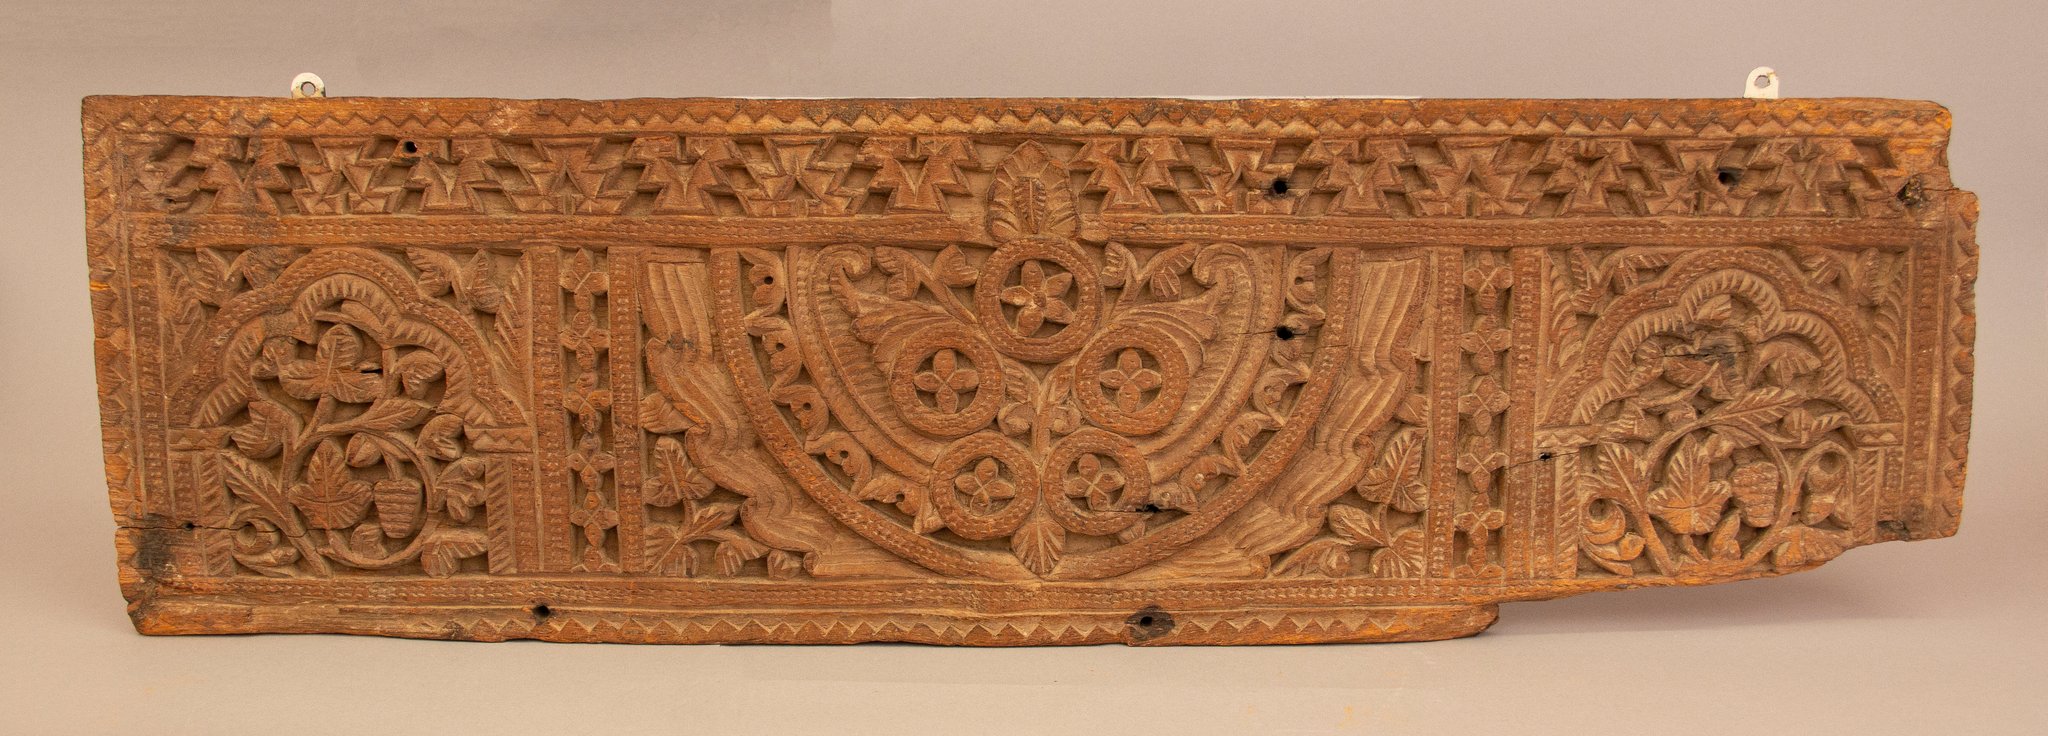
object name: panel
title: Carved Wood Panel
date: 701-900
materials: wood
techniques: carving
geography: iraq